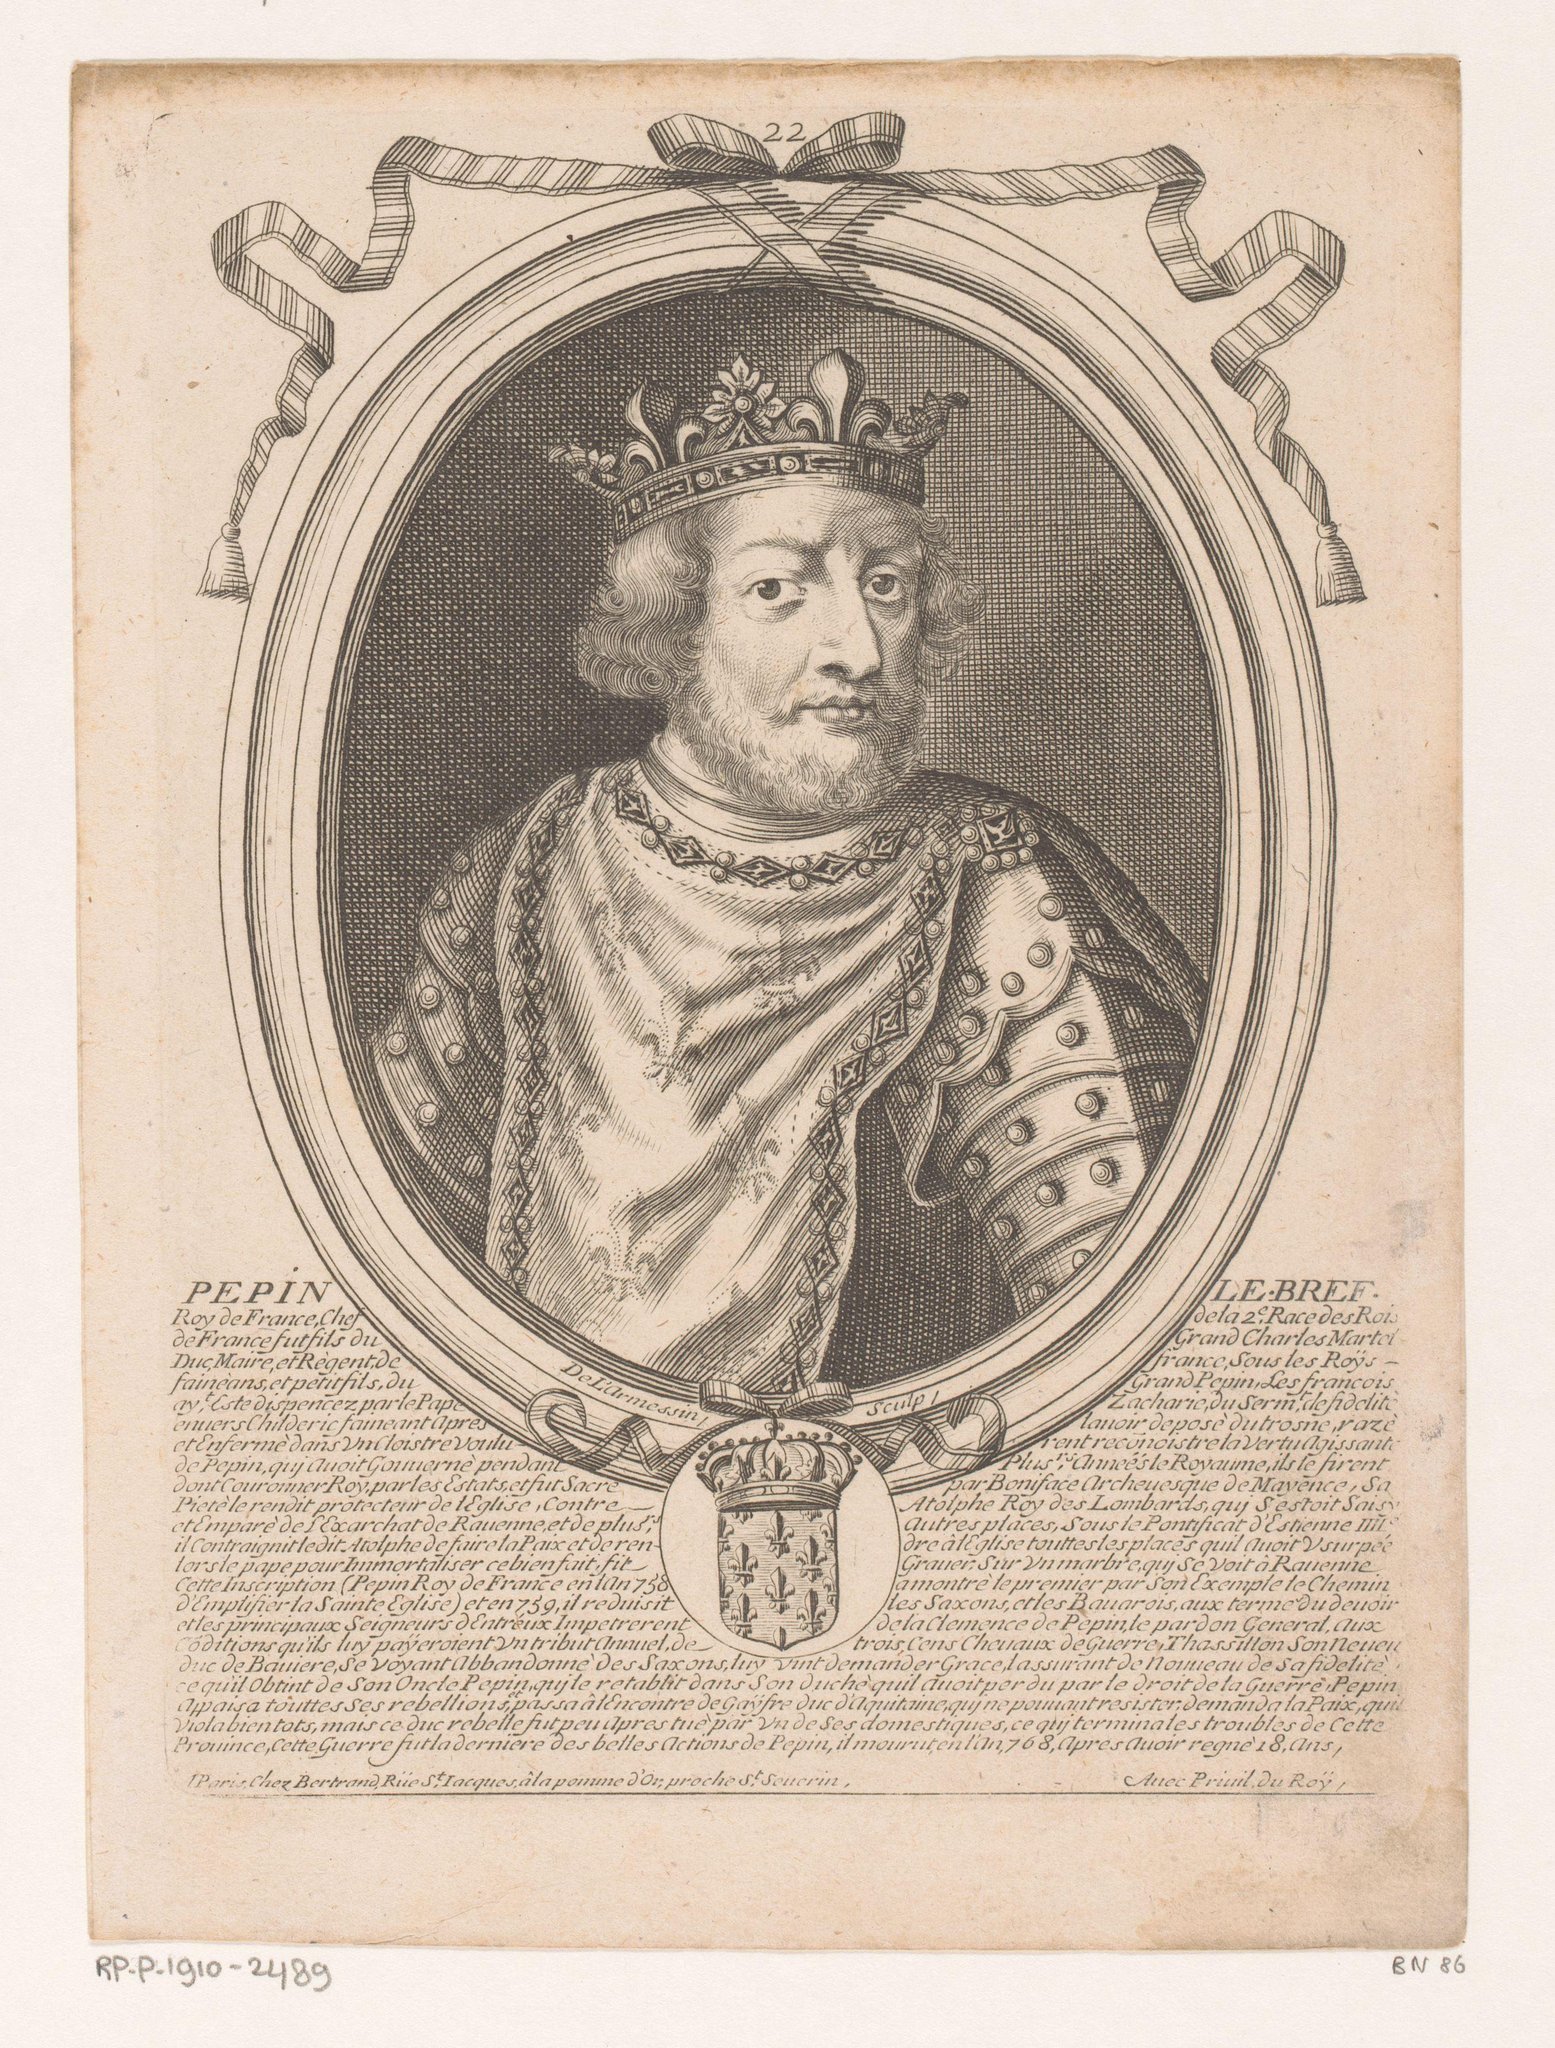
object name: print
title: Portretten van prominente figuren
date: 1647-1678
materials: paper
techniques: engraving, etching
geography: france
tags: liège, historical persons, king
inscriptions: collector's mark: Lugt 2228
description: Maakt deel uit van een grootschalige serie met portretten van prominente figuren. Binnen de serie bevindt zich een sectie getiteld 'Les Augustes Représentations De tous les Roys De France depuis Pharamond Iusqu'à Louys XIIII'. De serie werd respectievelijk uitgegeven door Pierre Bertrand, door zijn weduwe en door De Larmessin zelf.